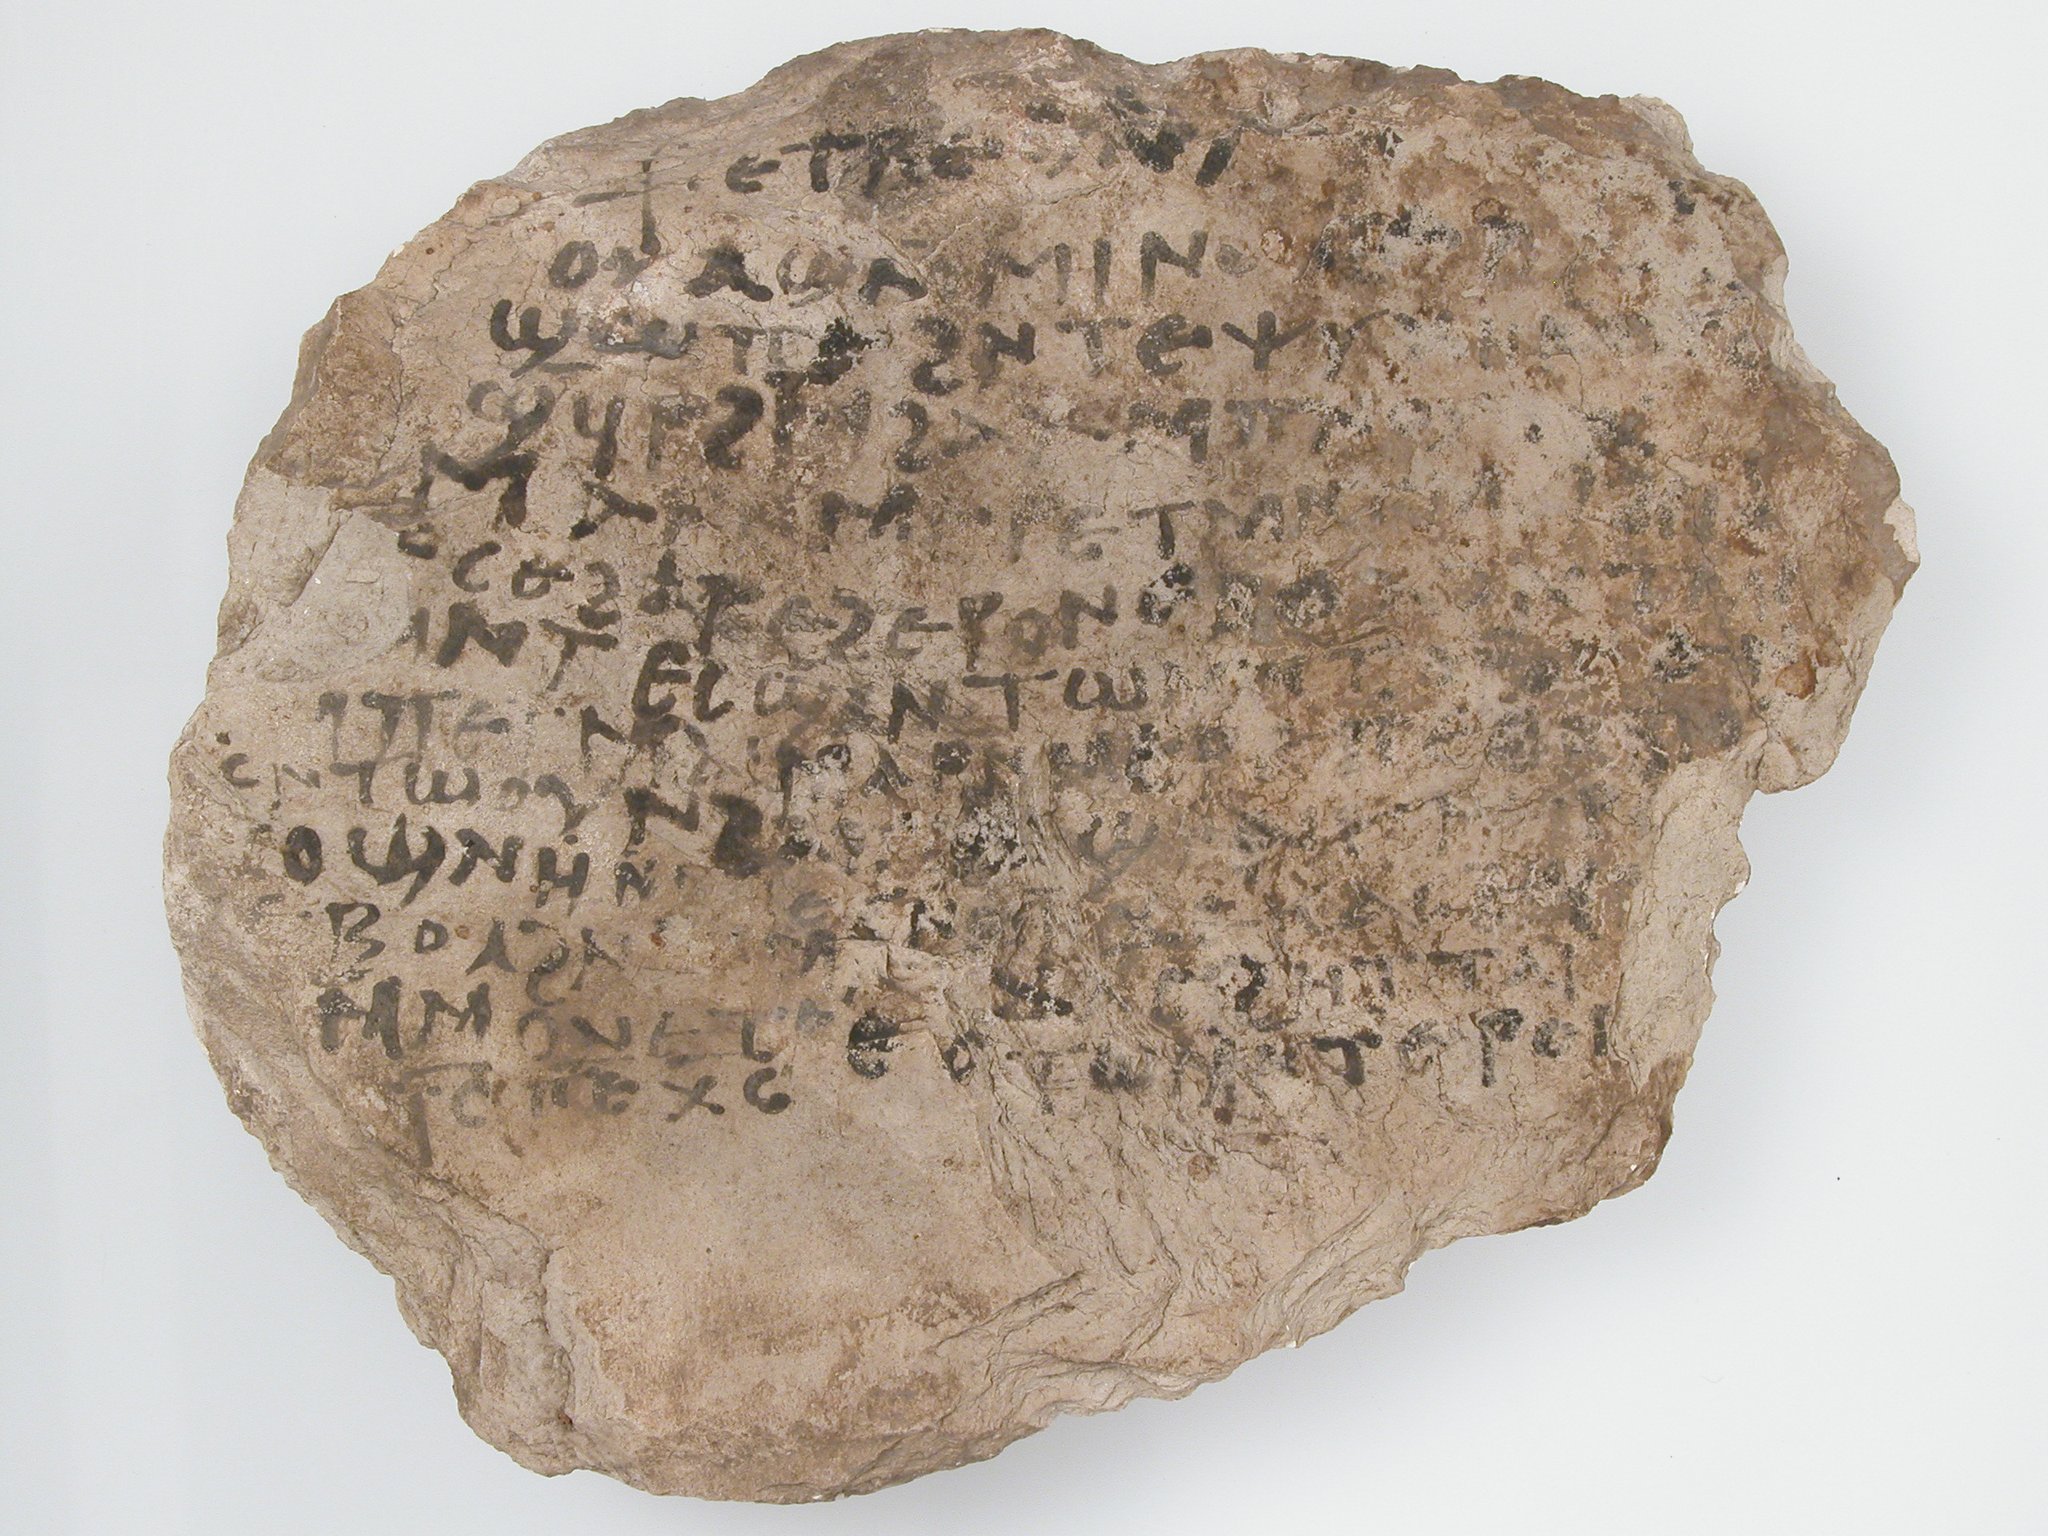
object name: ostrakon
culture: coptic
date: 601-700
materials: ink, limestone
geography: egypt